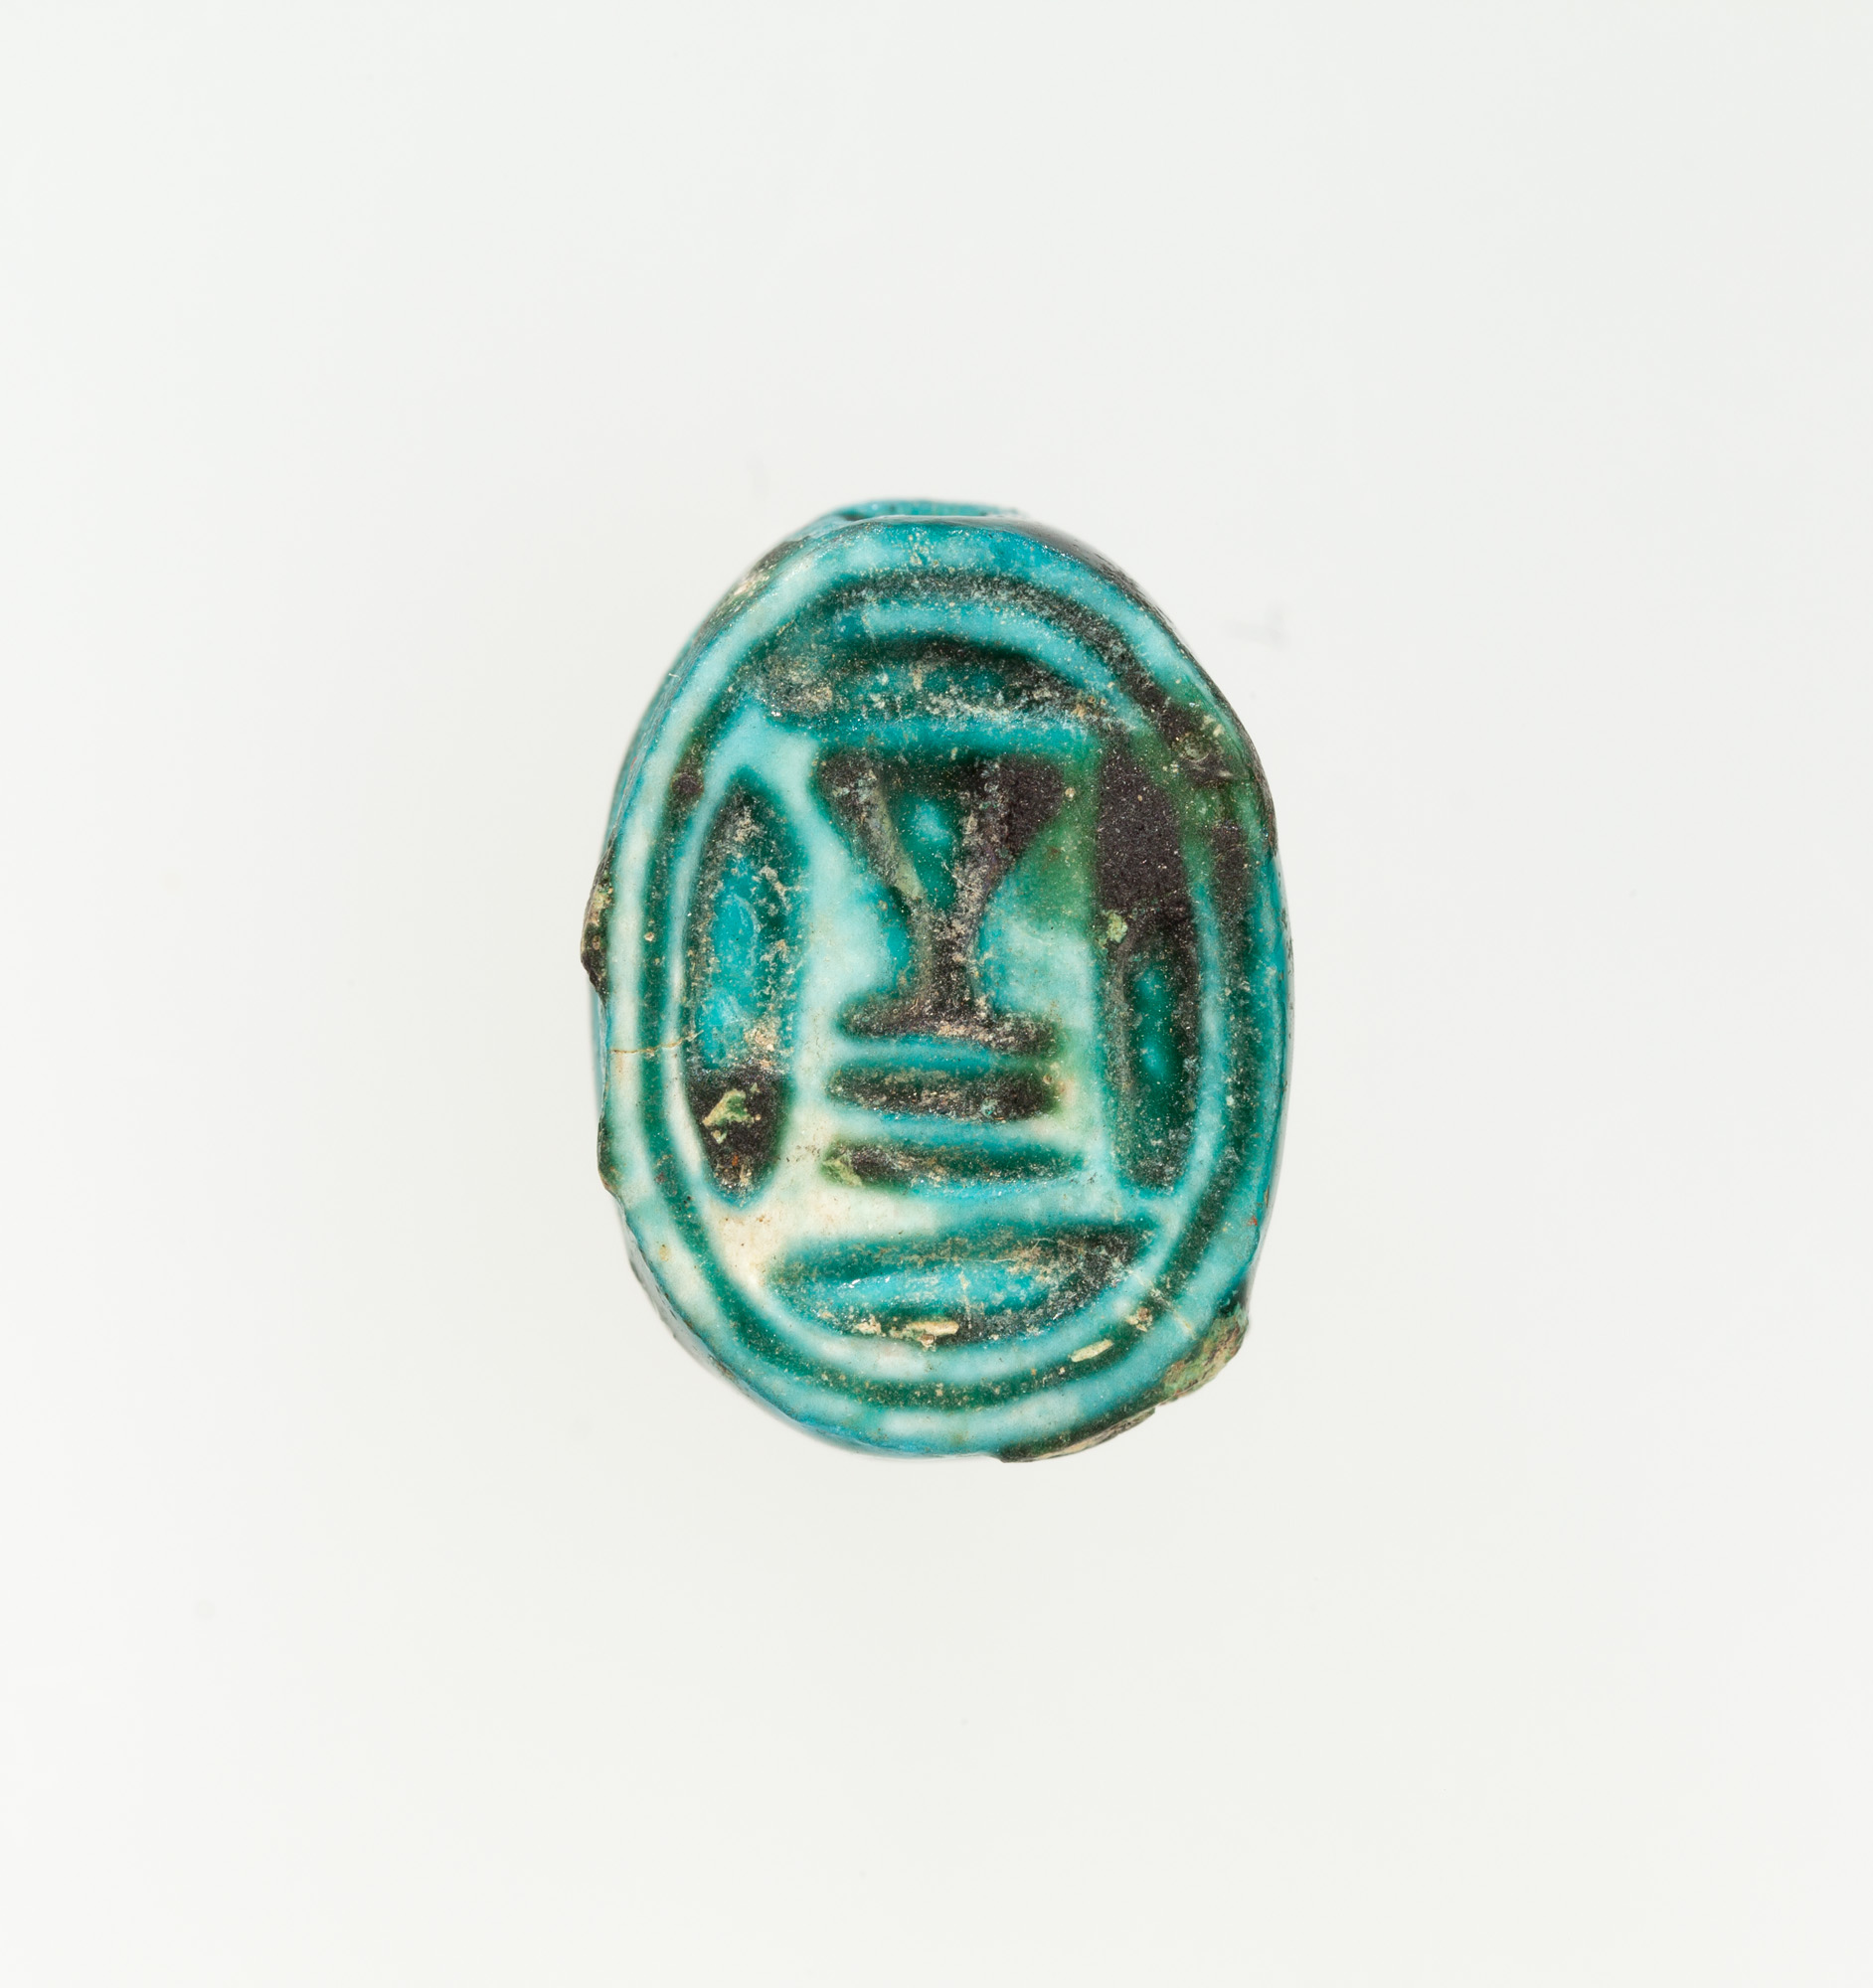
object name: scarab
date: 1479-1458 BCE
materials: faience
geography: egypt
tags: scarabs